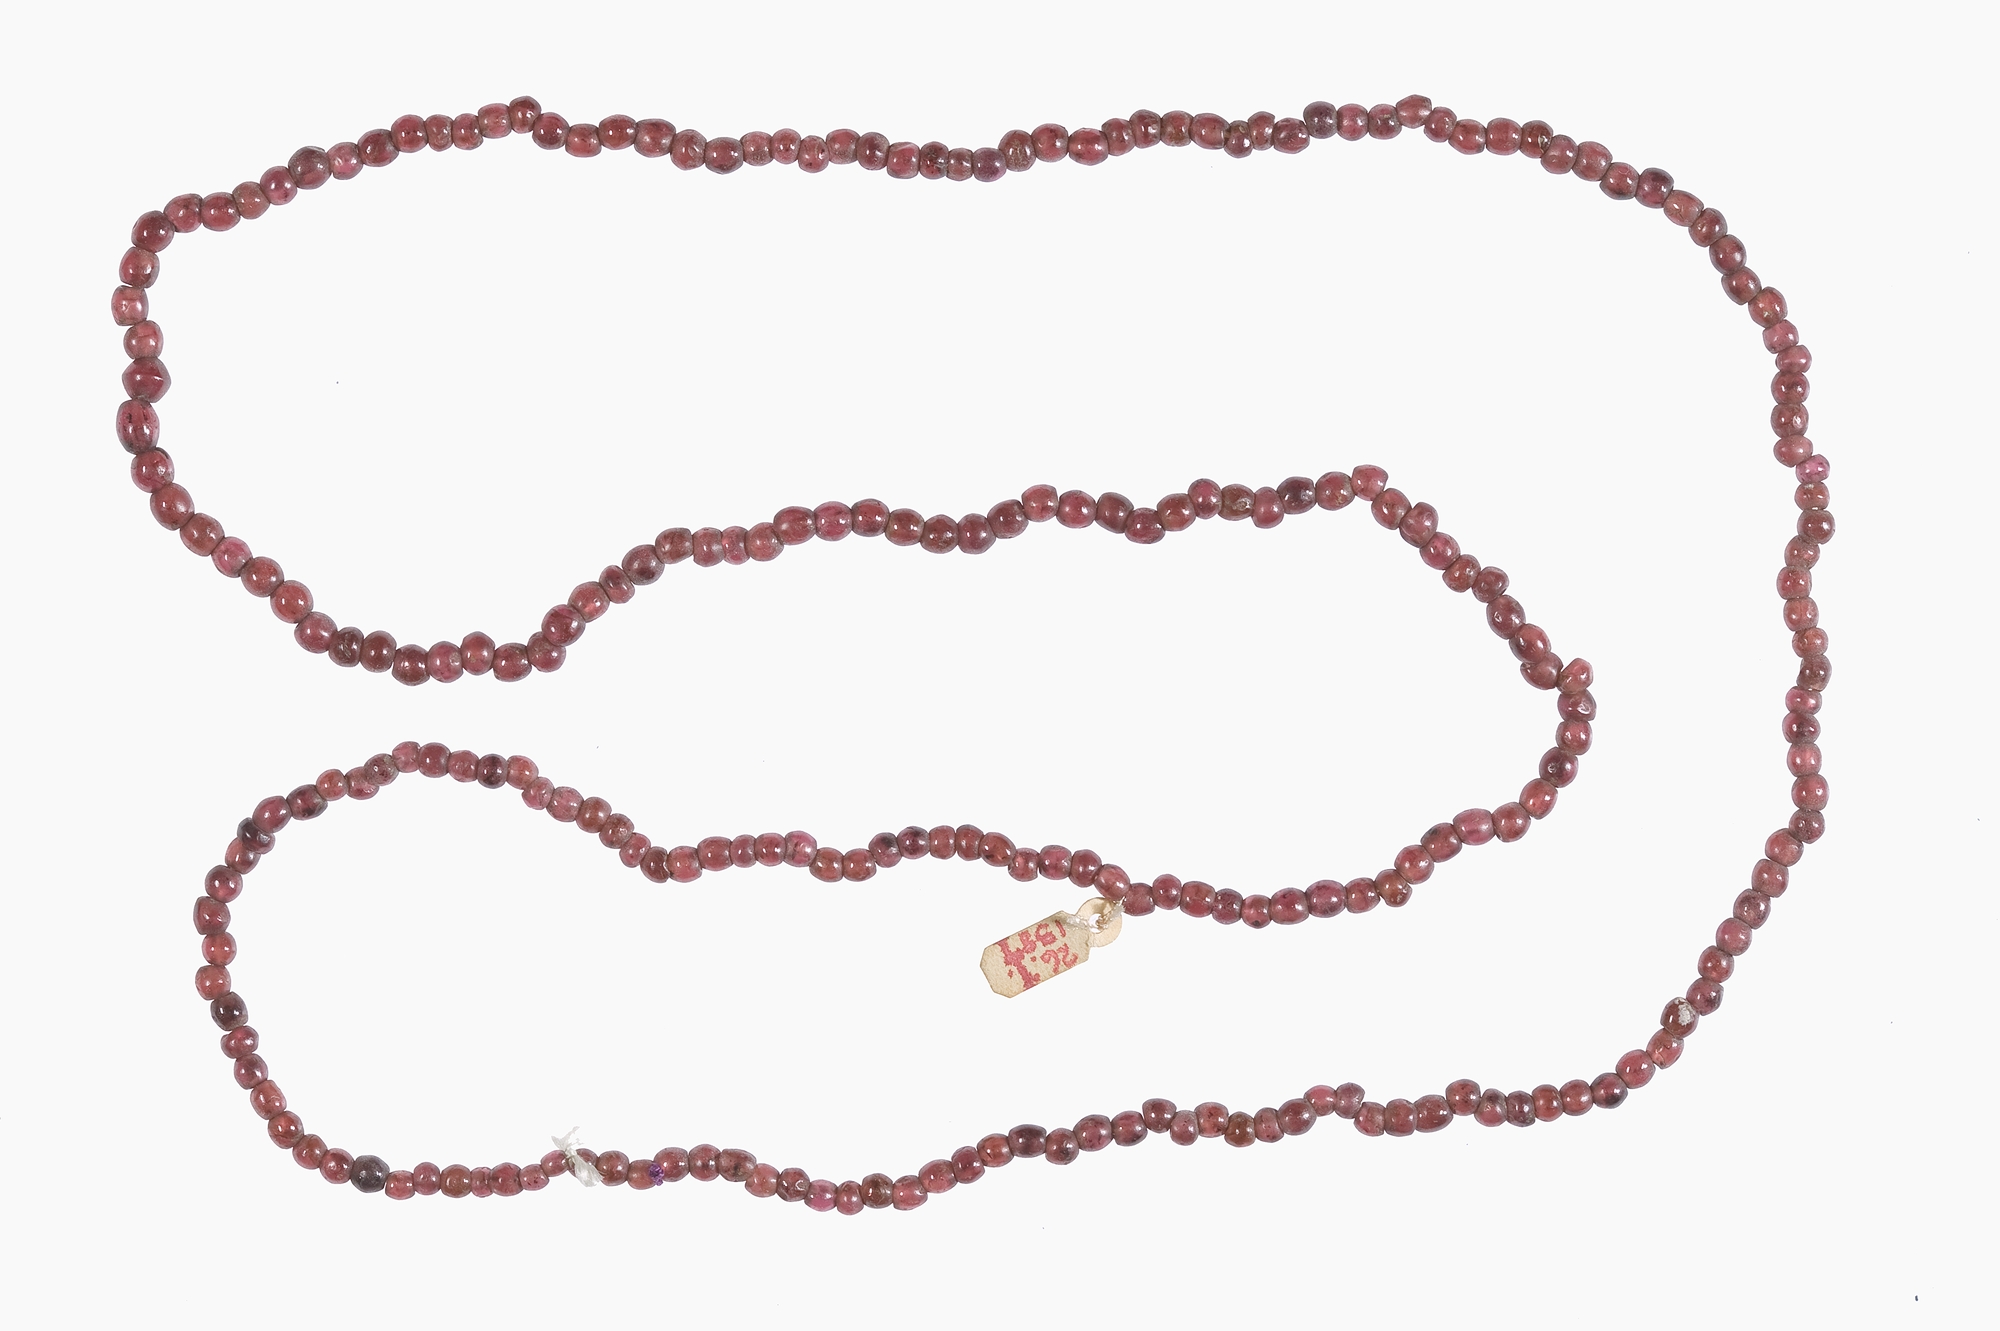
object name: necklace, bead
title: Necklace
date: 1991-1450 BCE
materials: gemstone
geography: egypt